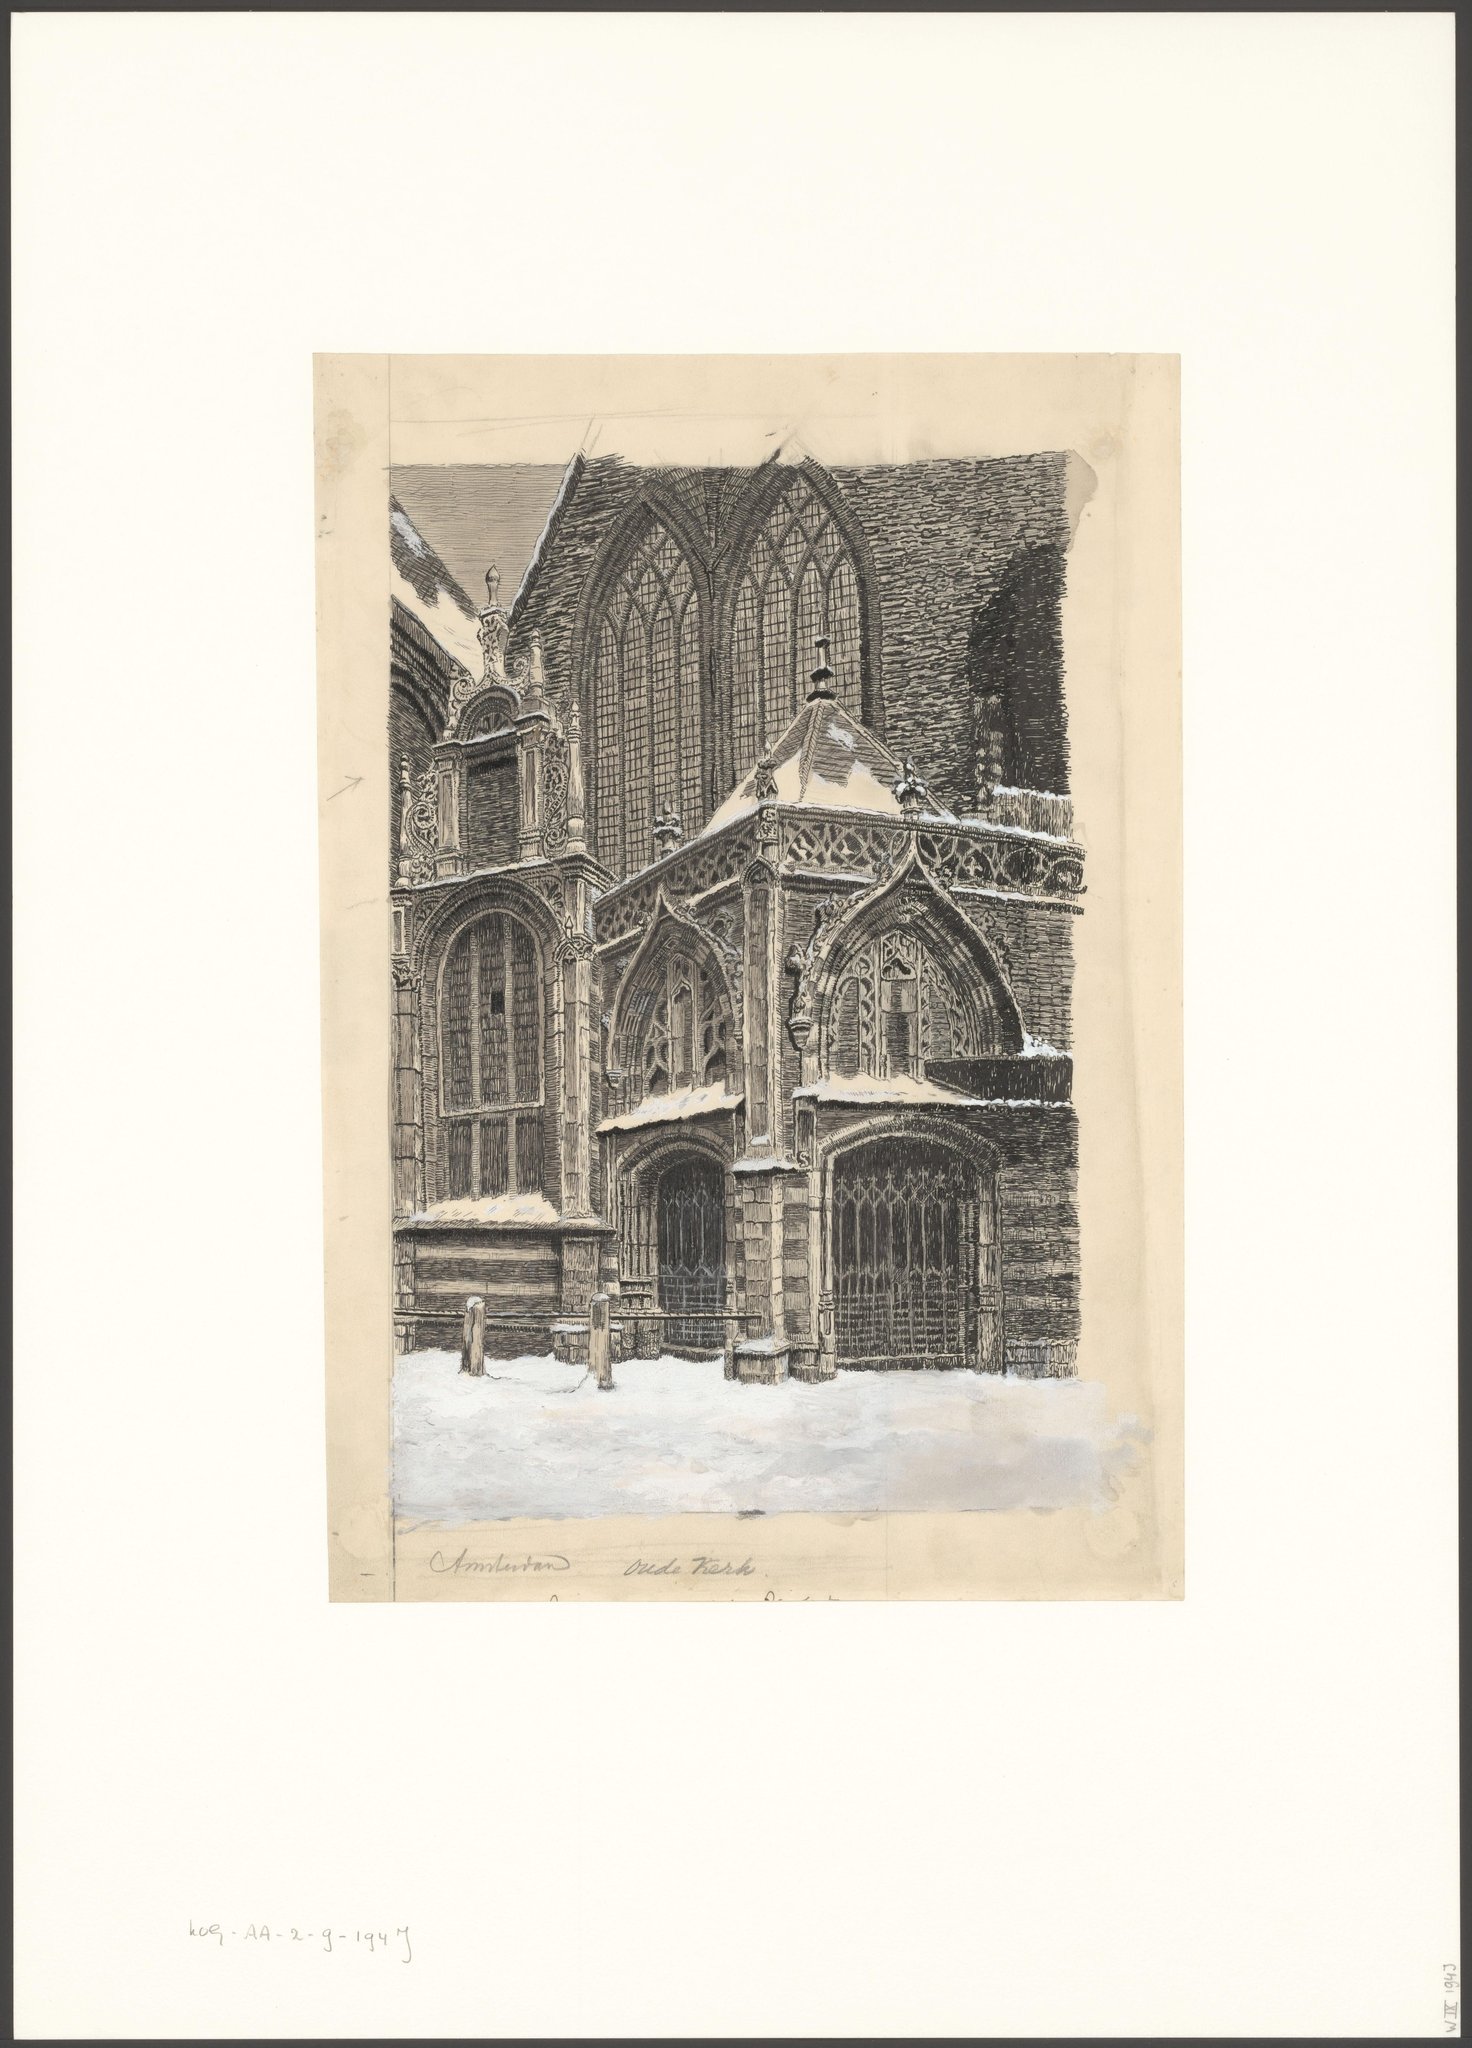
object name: drawing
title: Gezicht op de Oude Kerk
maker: Anonymous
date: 1850-1950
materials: paint, ink, paper, pencil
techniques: brush, pen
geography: amsterdam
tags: city-view in general; 'veduta', parts of church exterior and annexes: façade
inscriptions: inscription: ‘Amsterdam / Oude Kerk’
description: Tekening binnen de Atlas Van Eck ingedeeld op wijknummer 9.